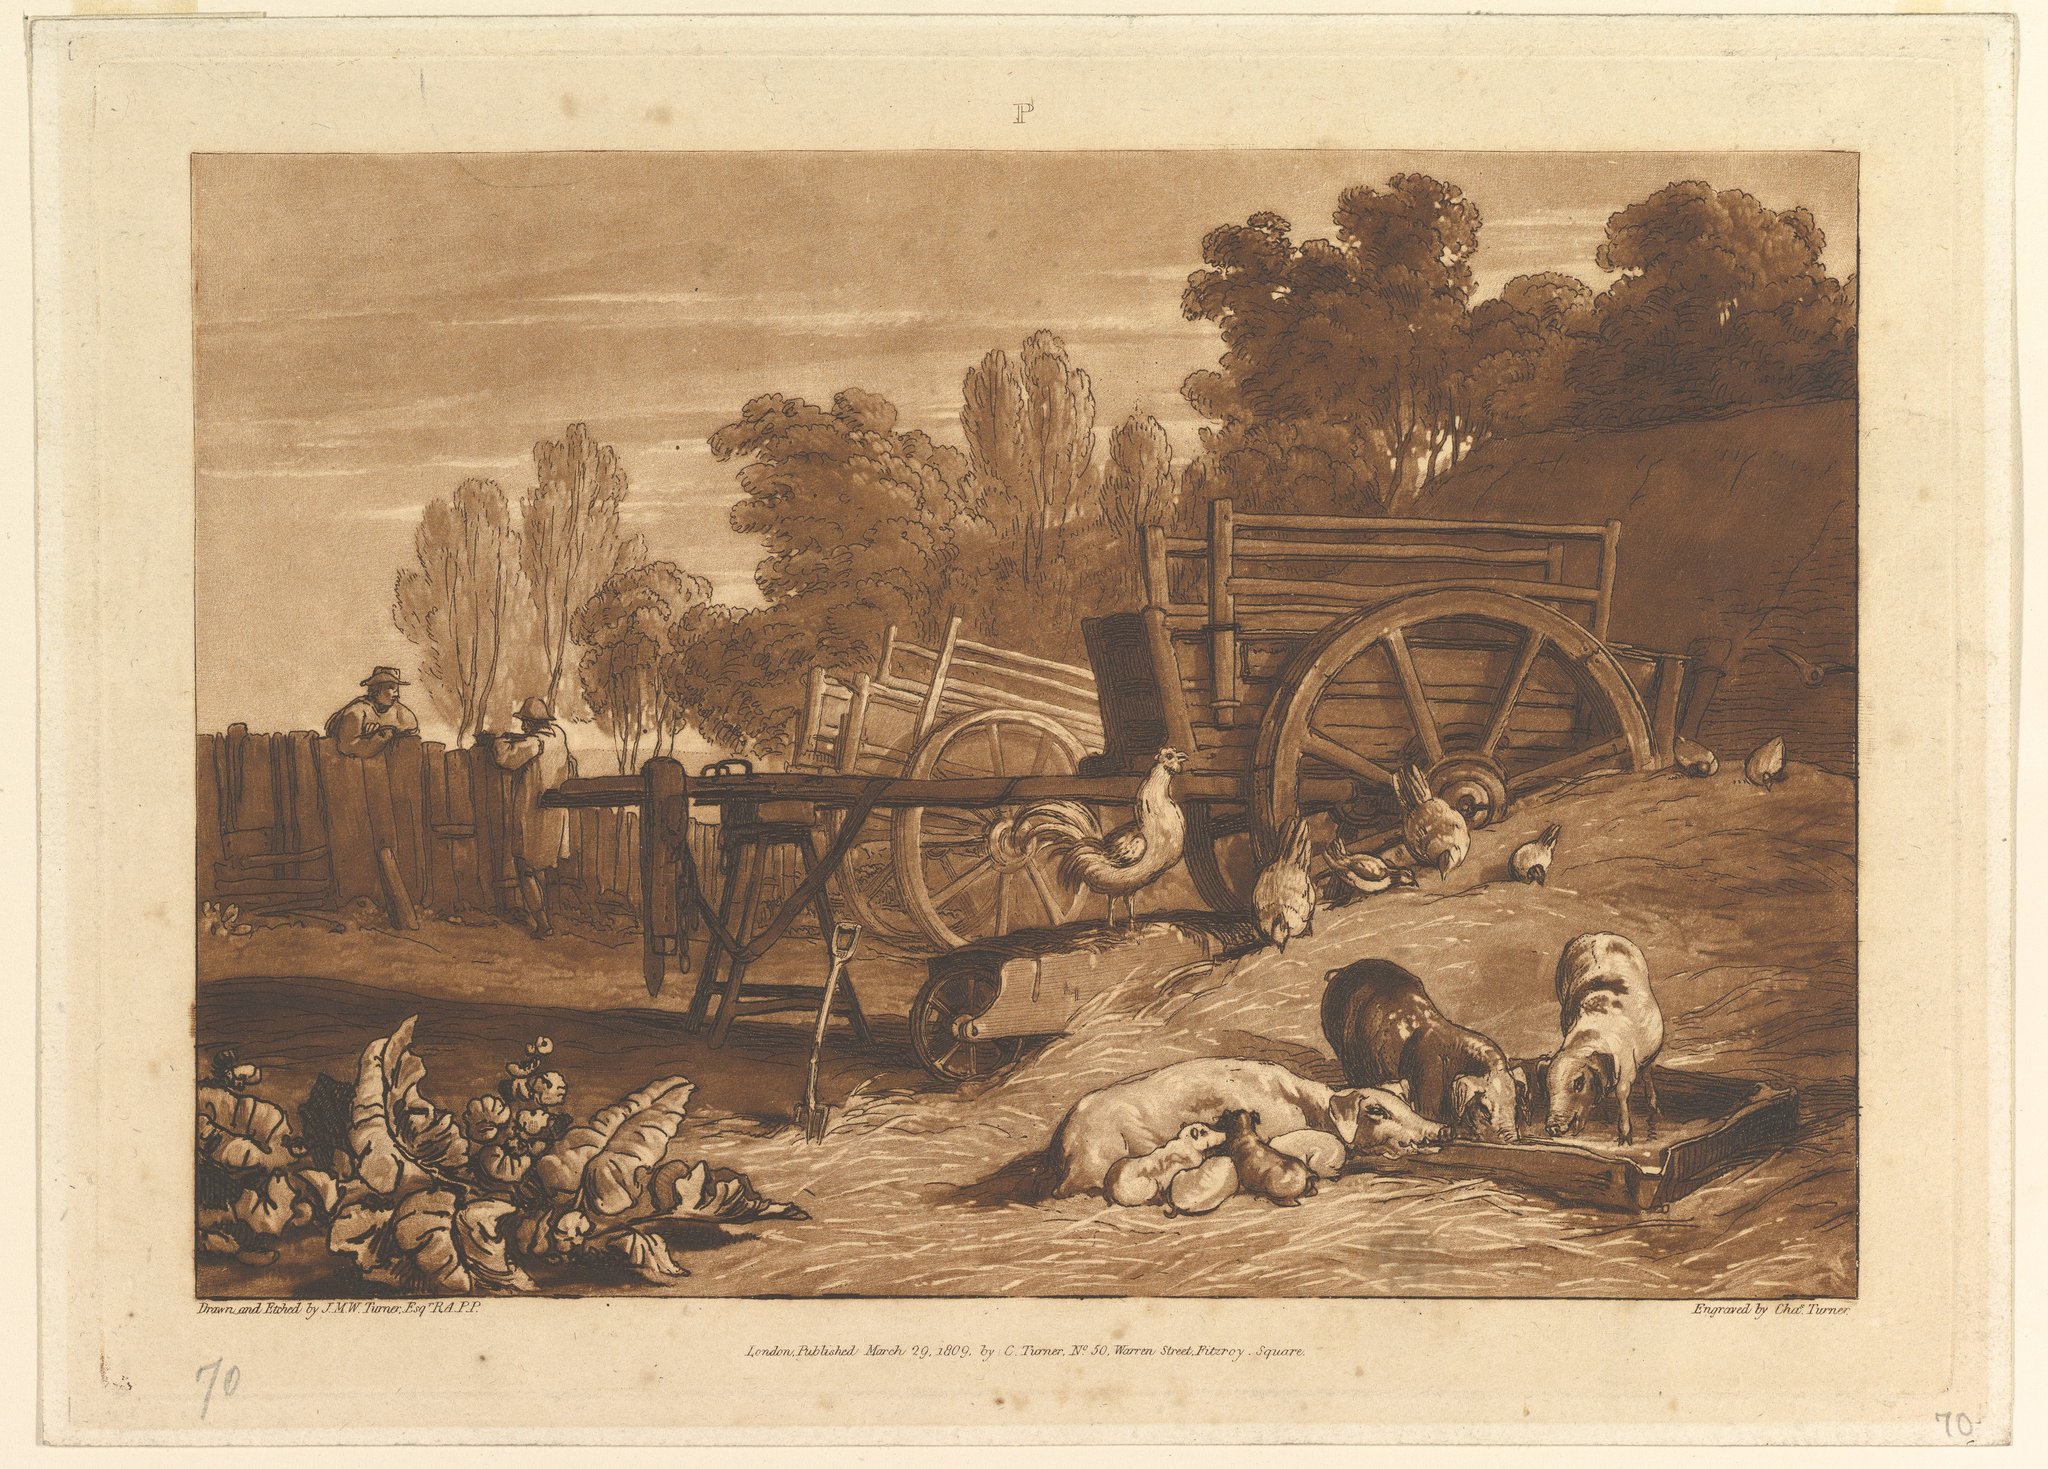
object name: print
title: The Farm-Yard with the Cock (Liber Studiorum, part IV, plate 17)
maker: joseph mallord william turner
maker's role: artist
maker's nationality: british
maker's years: 1775-1851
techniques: etching, mezzotint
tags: human figures,farms,roosters,carriages